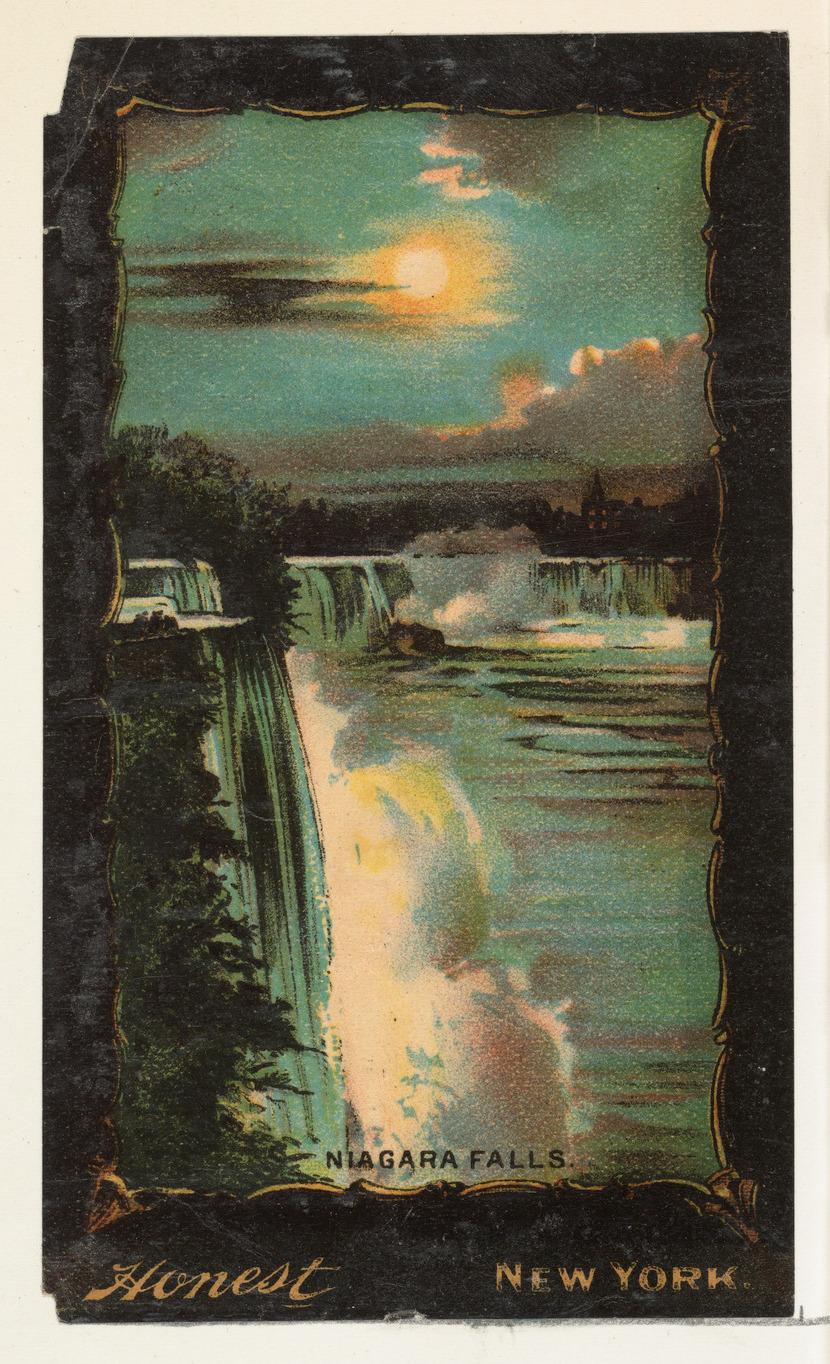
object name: print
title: Niagara Falls, from the Transparencies series (N137) issued by W. Duke, Sons & Co. to promote Honest Long Cut Tobacco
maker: w. duke, sons & co.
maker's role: publisher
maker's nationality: american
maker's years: 1870-1920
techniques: color lithograph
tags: waterfalls